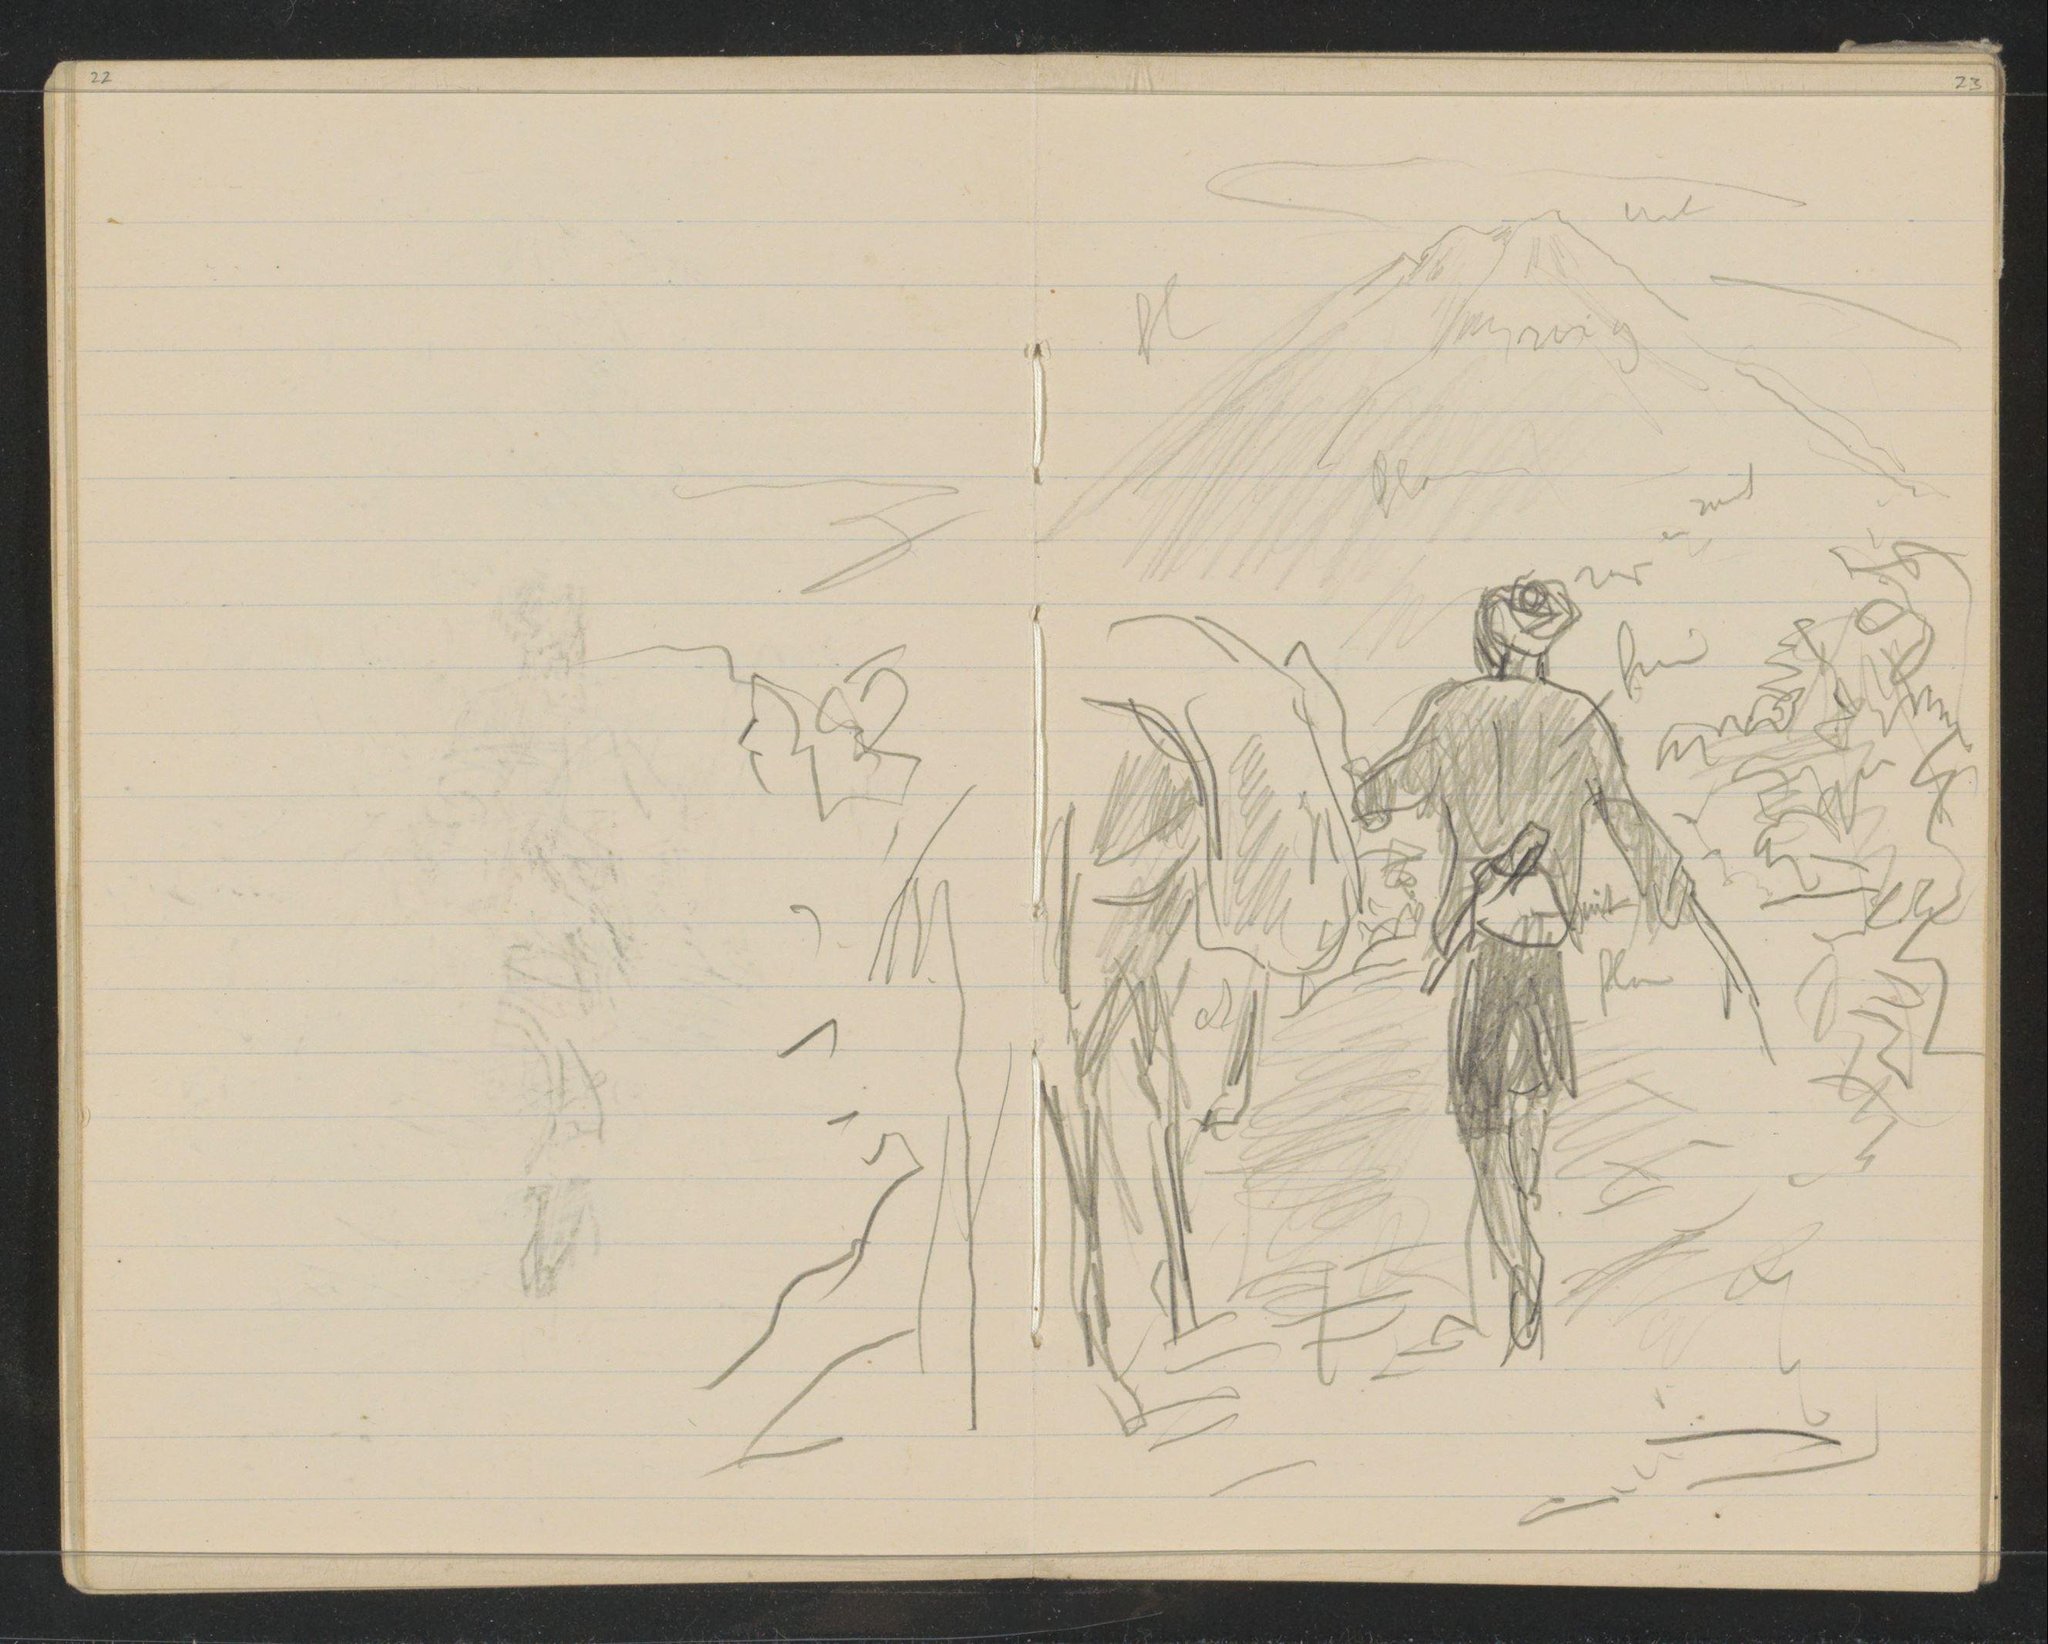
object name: sketchbook leaf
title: Indonesiër op een pad dat richting een vulkaan leidt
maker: marius bauer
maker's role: draughtsman, print maker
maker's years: 1867-1932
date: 1931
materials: pencil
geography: java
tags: asiatic races and peoples, hacking and thrusting weapons: sword, road, path, volcano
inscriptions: kleurnotitie, handgeschreven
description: De man draagt een zwaard in een band om zijn middel. Pagina 22 en 23 uit een schetsboek met 74 bladen.